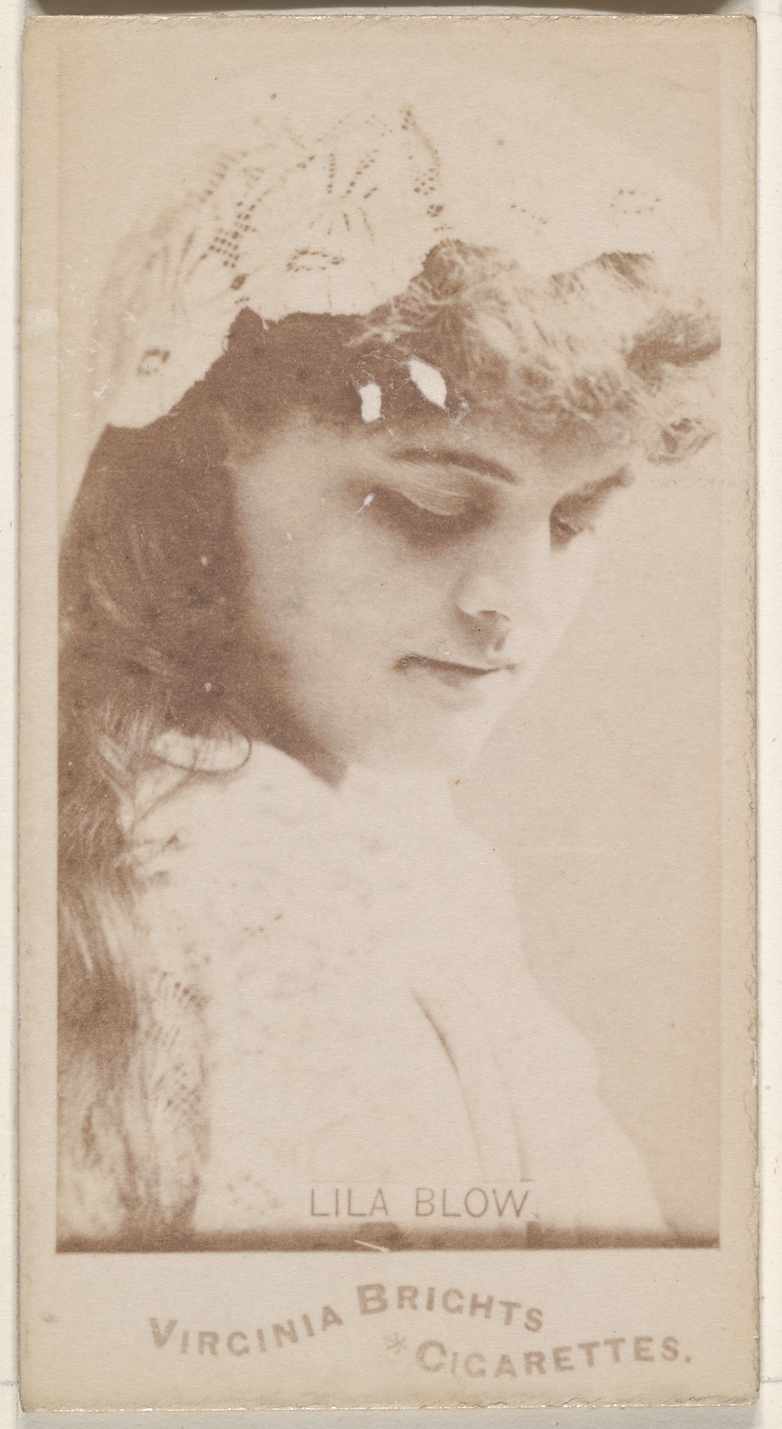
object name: photograph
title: Lila Blow, from the Actors and Actresses series (N45, Type 1) for Virginia Brights Cigarettes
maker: allen & ginter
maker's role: publisher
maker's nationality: american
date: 1888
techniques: albumen silver print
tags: portraits,women,actresses